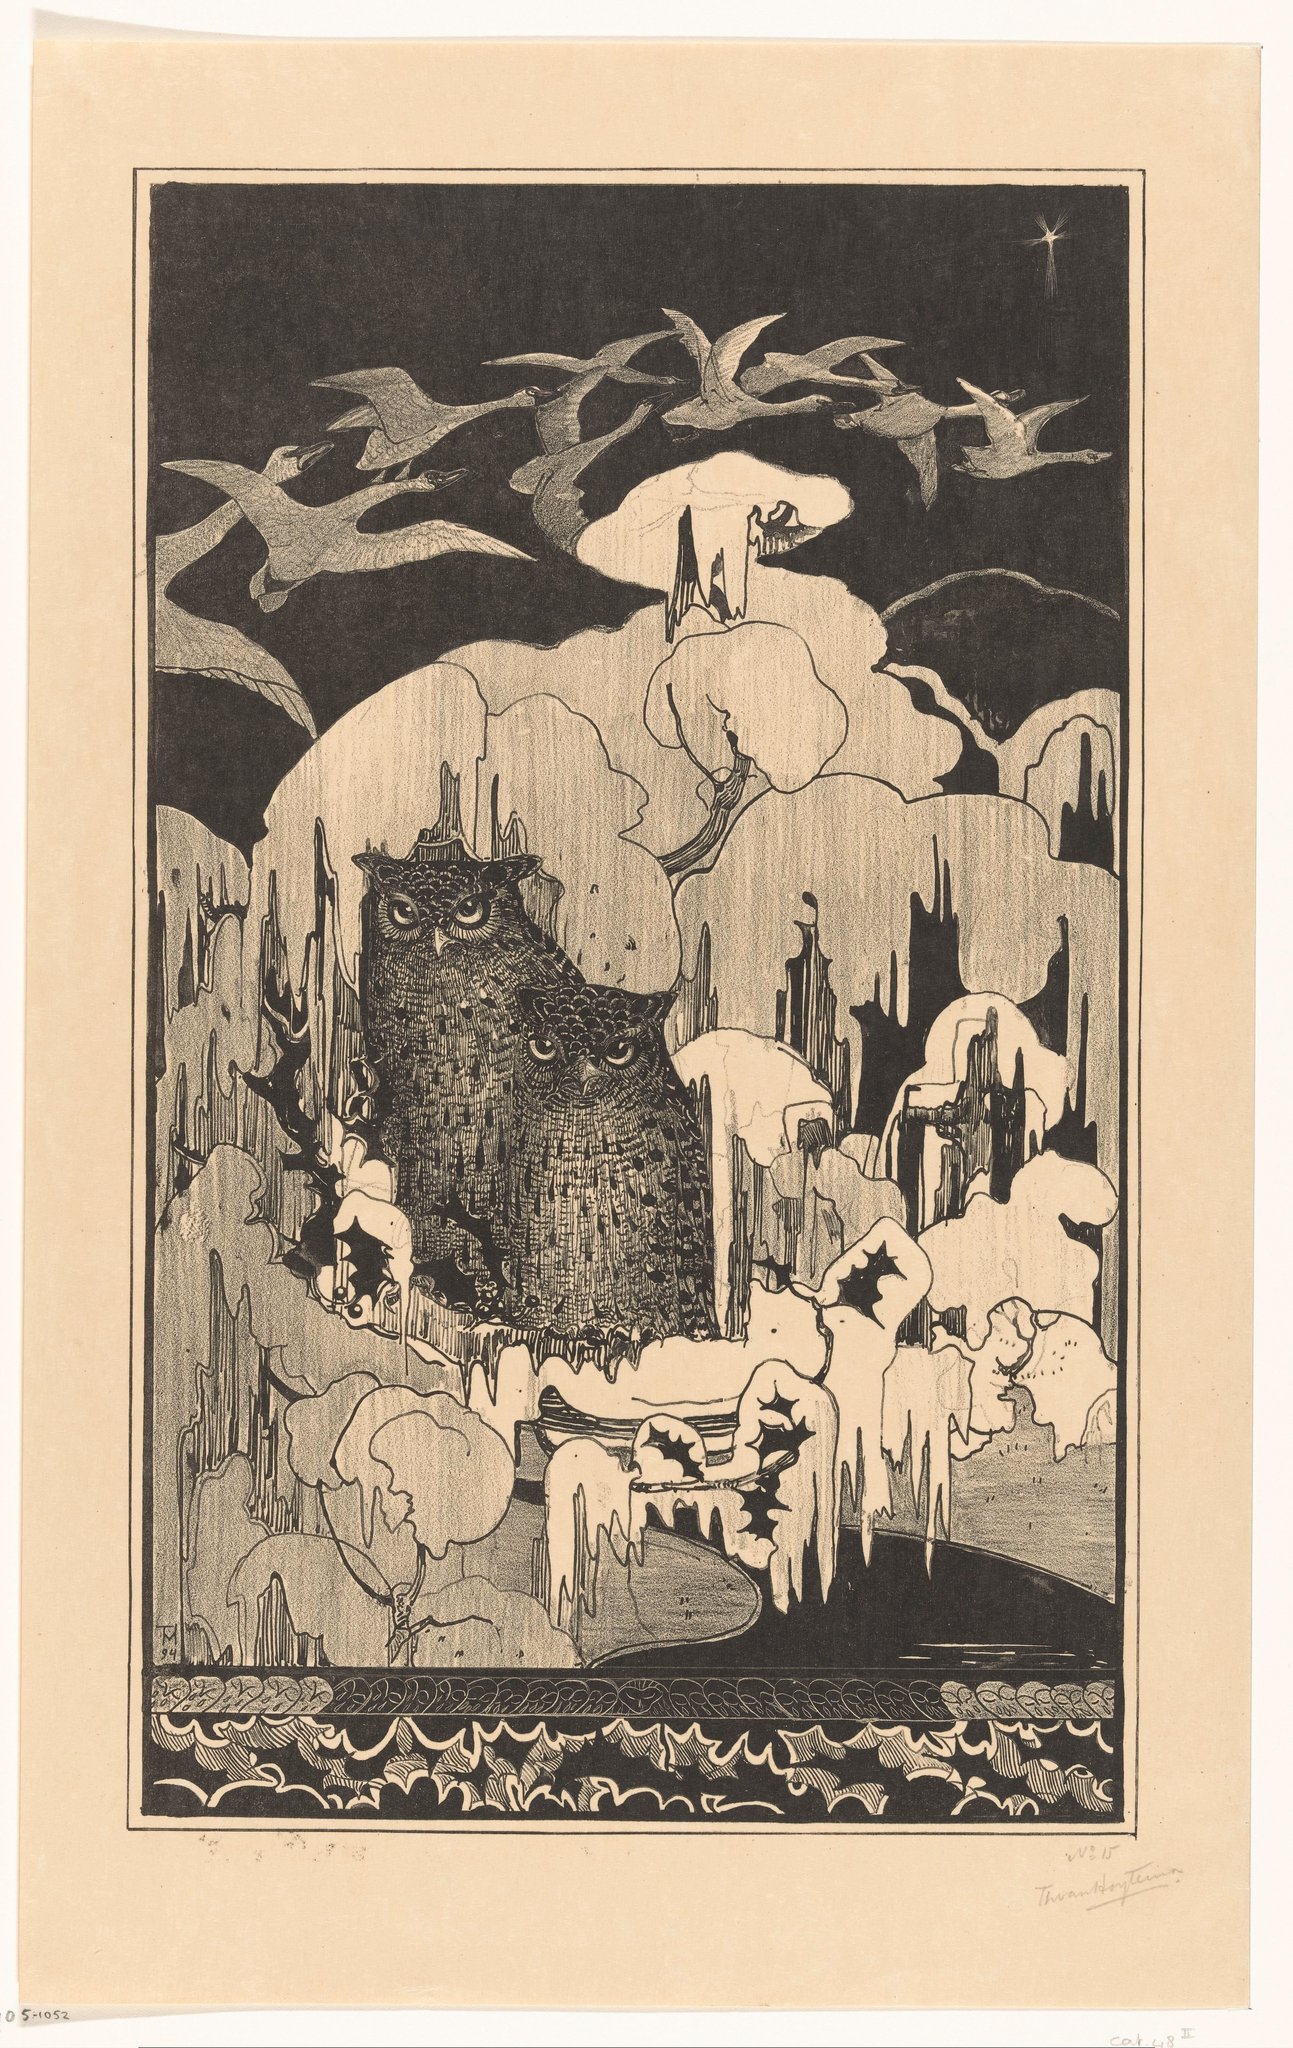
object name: print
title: Kerstnacht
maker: theo van hoytema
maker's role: draughtsman, painter, print maker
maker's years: 1863-1917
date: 1894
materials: paper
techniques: lithograph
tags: christmas (non-liturgical celebration), geese (domestic waterbirds), owls, snow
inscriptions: collector's mark: Lugt 2228, number: ‘15’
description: Twee oehoes op besneeuwde takken. In de lucht vliegen ganzen.